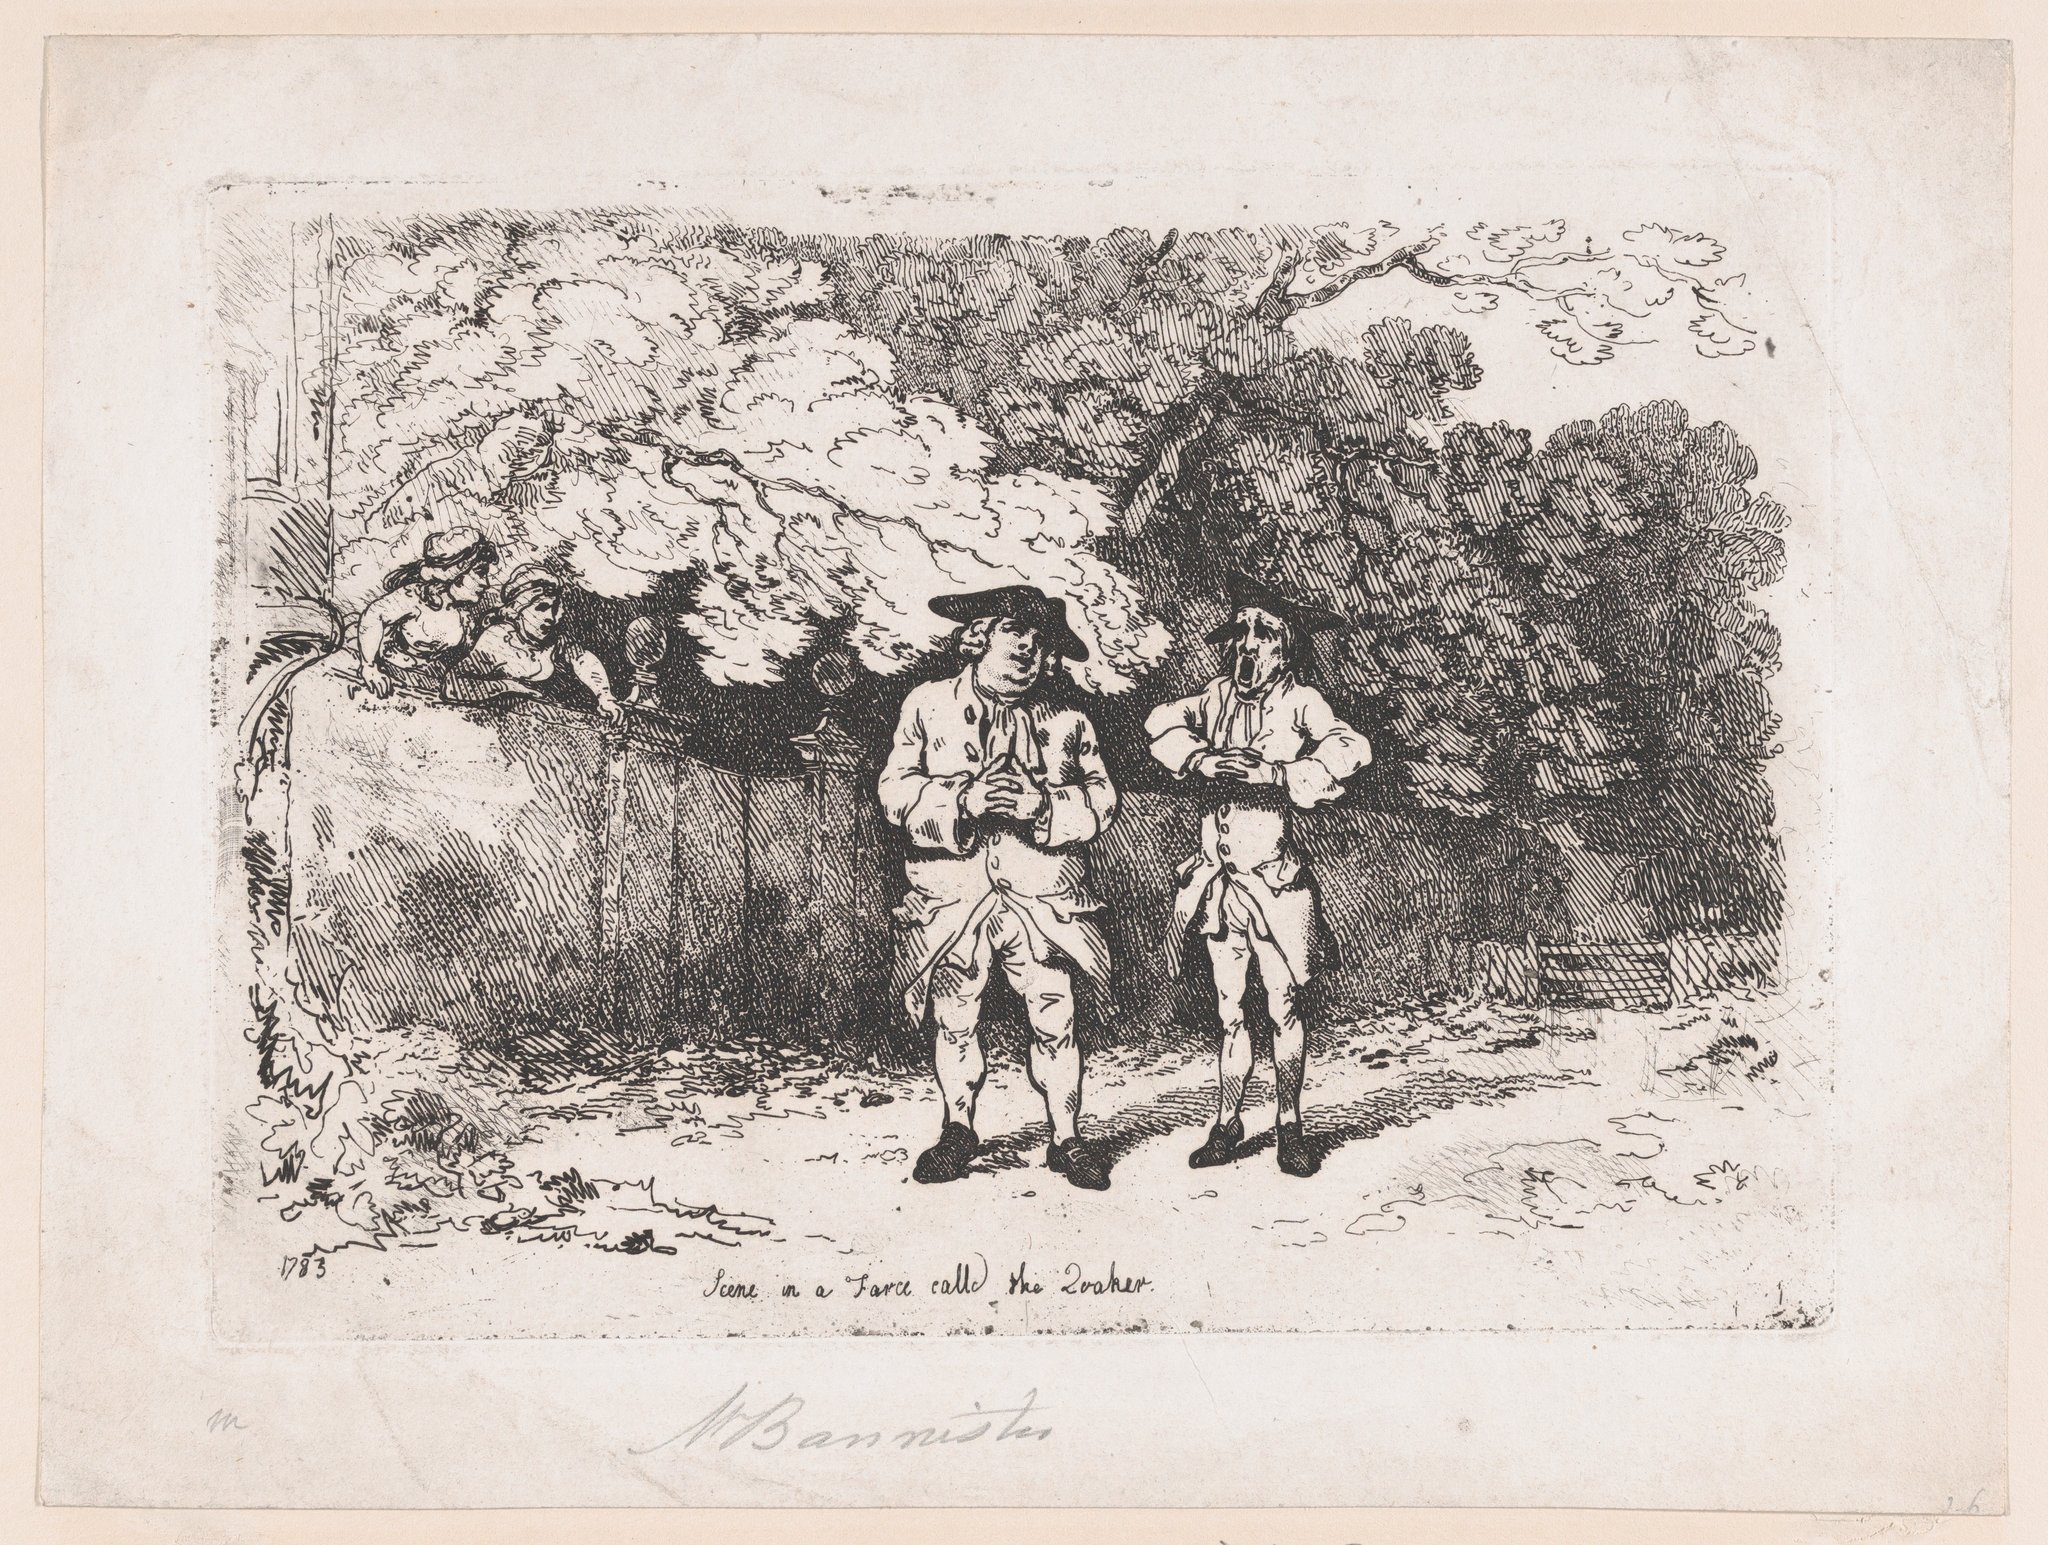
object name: print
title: Scene in a Farce called The Quaker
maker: thomas rowlandson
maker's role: artist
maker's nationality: british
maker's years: 1757-1827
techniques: etching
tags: men